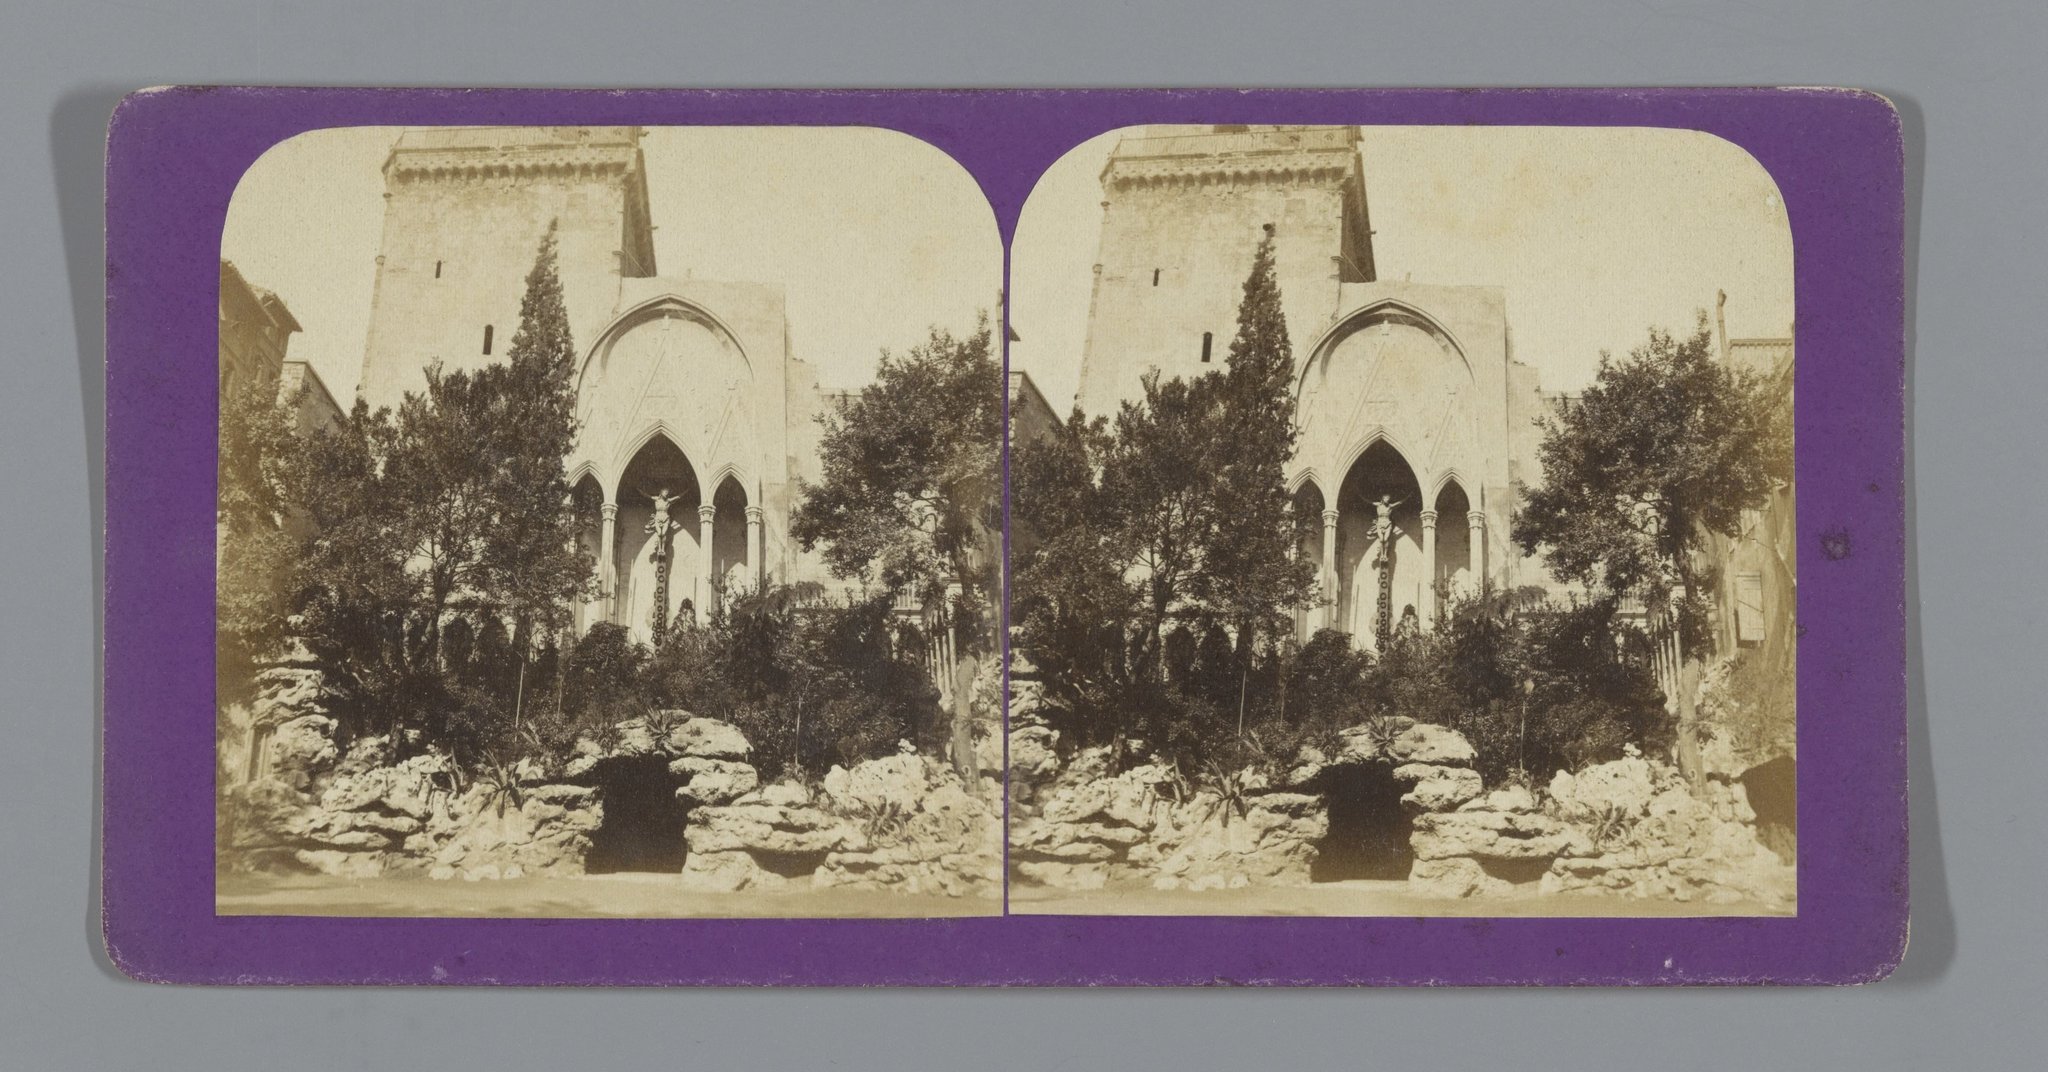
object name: stereograph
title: Calvarium van de Notre-Dame des Accoules te Marseille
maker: jean andrieu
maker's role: fotograaf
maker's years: 1816-1872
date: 1862-1876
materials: cardboard, photographic support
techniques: albumen print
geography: marseille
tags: church (exterior) - qq - small church, chapel, façade (of house or building)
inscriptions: inscription: ‘Calvaire Marseille’, number: ‘588’